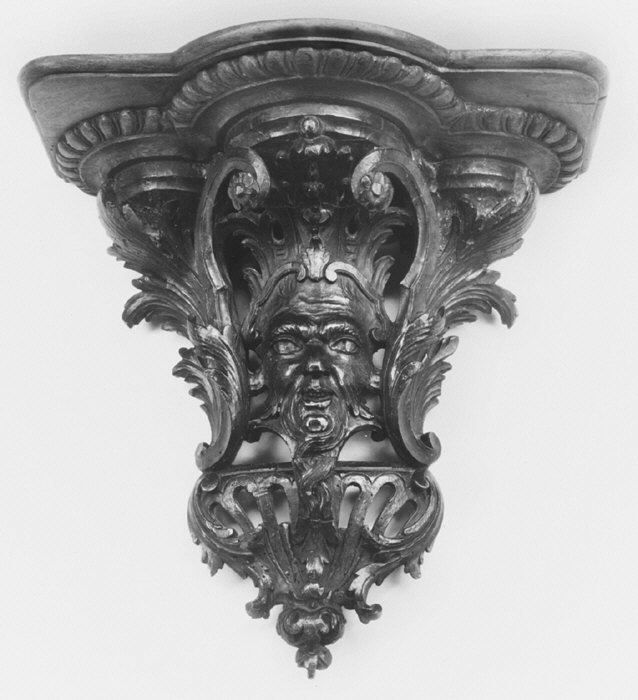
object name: wall bracket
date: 1725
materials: wood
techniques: carving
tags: faces